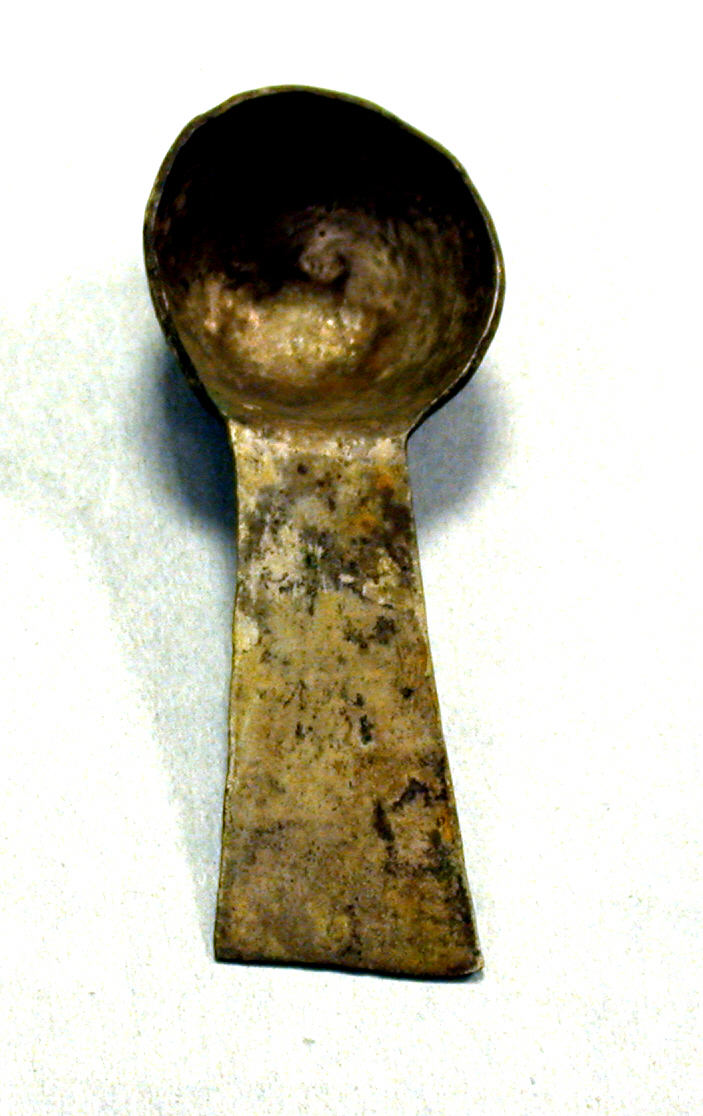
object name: spoon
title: Hammered Silver Spoon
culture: peruvian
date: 701-1566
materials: gilt, silver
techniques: hammering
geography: peru